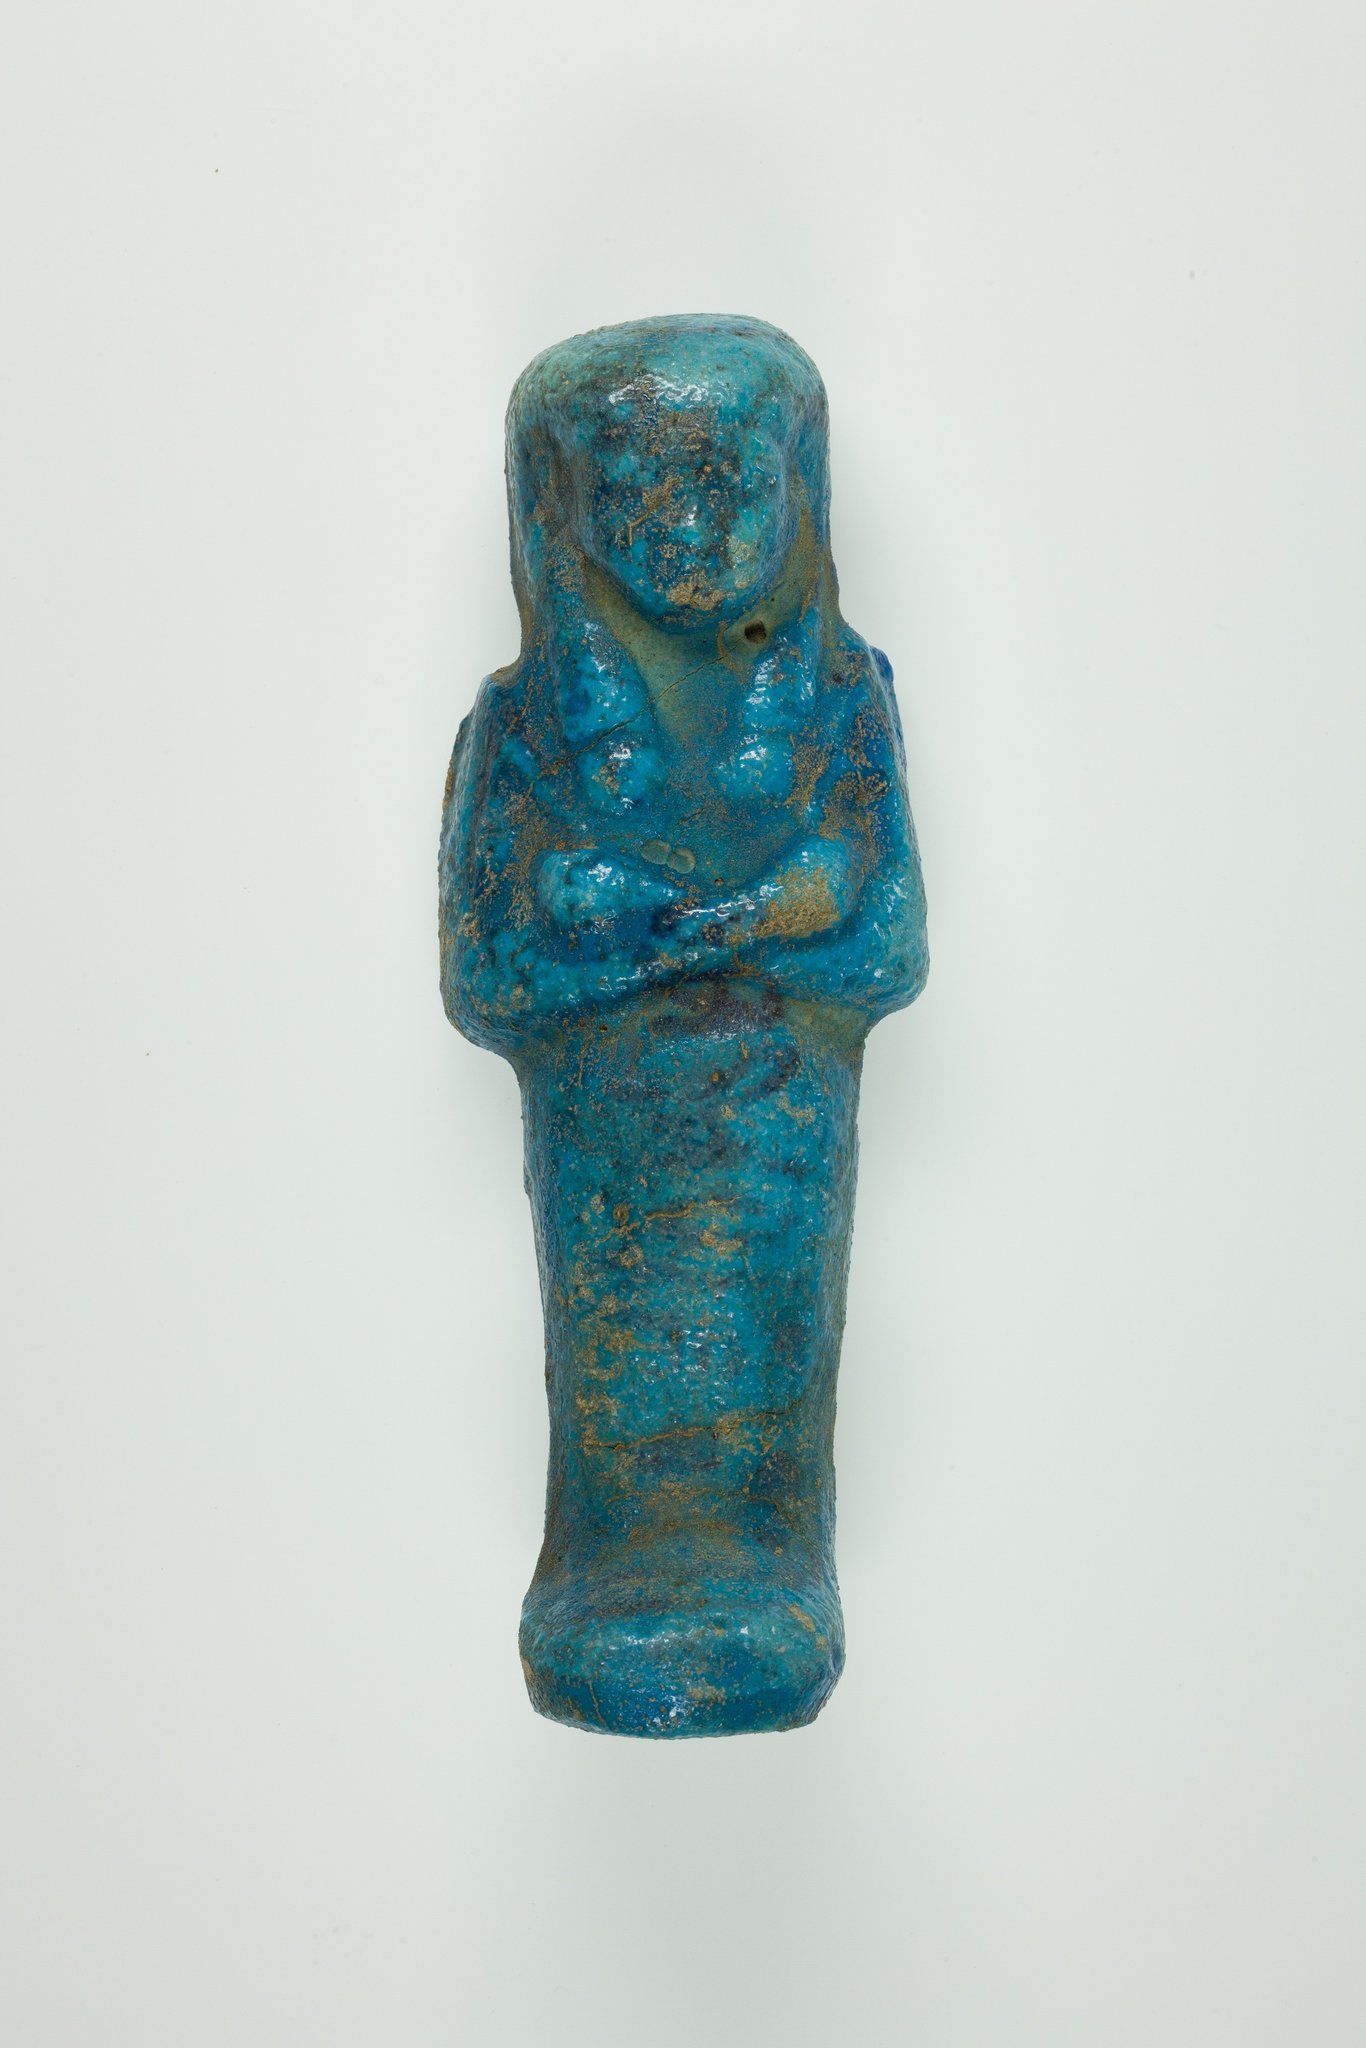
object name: worker shabti, henettawy c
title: Worker Shabti of Henettawy (C), Daughter of Isetemkheb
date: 990-970 BCE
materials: faience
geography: egypt